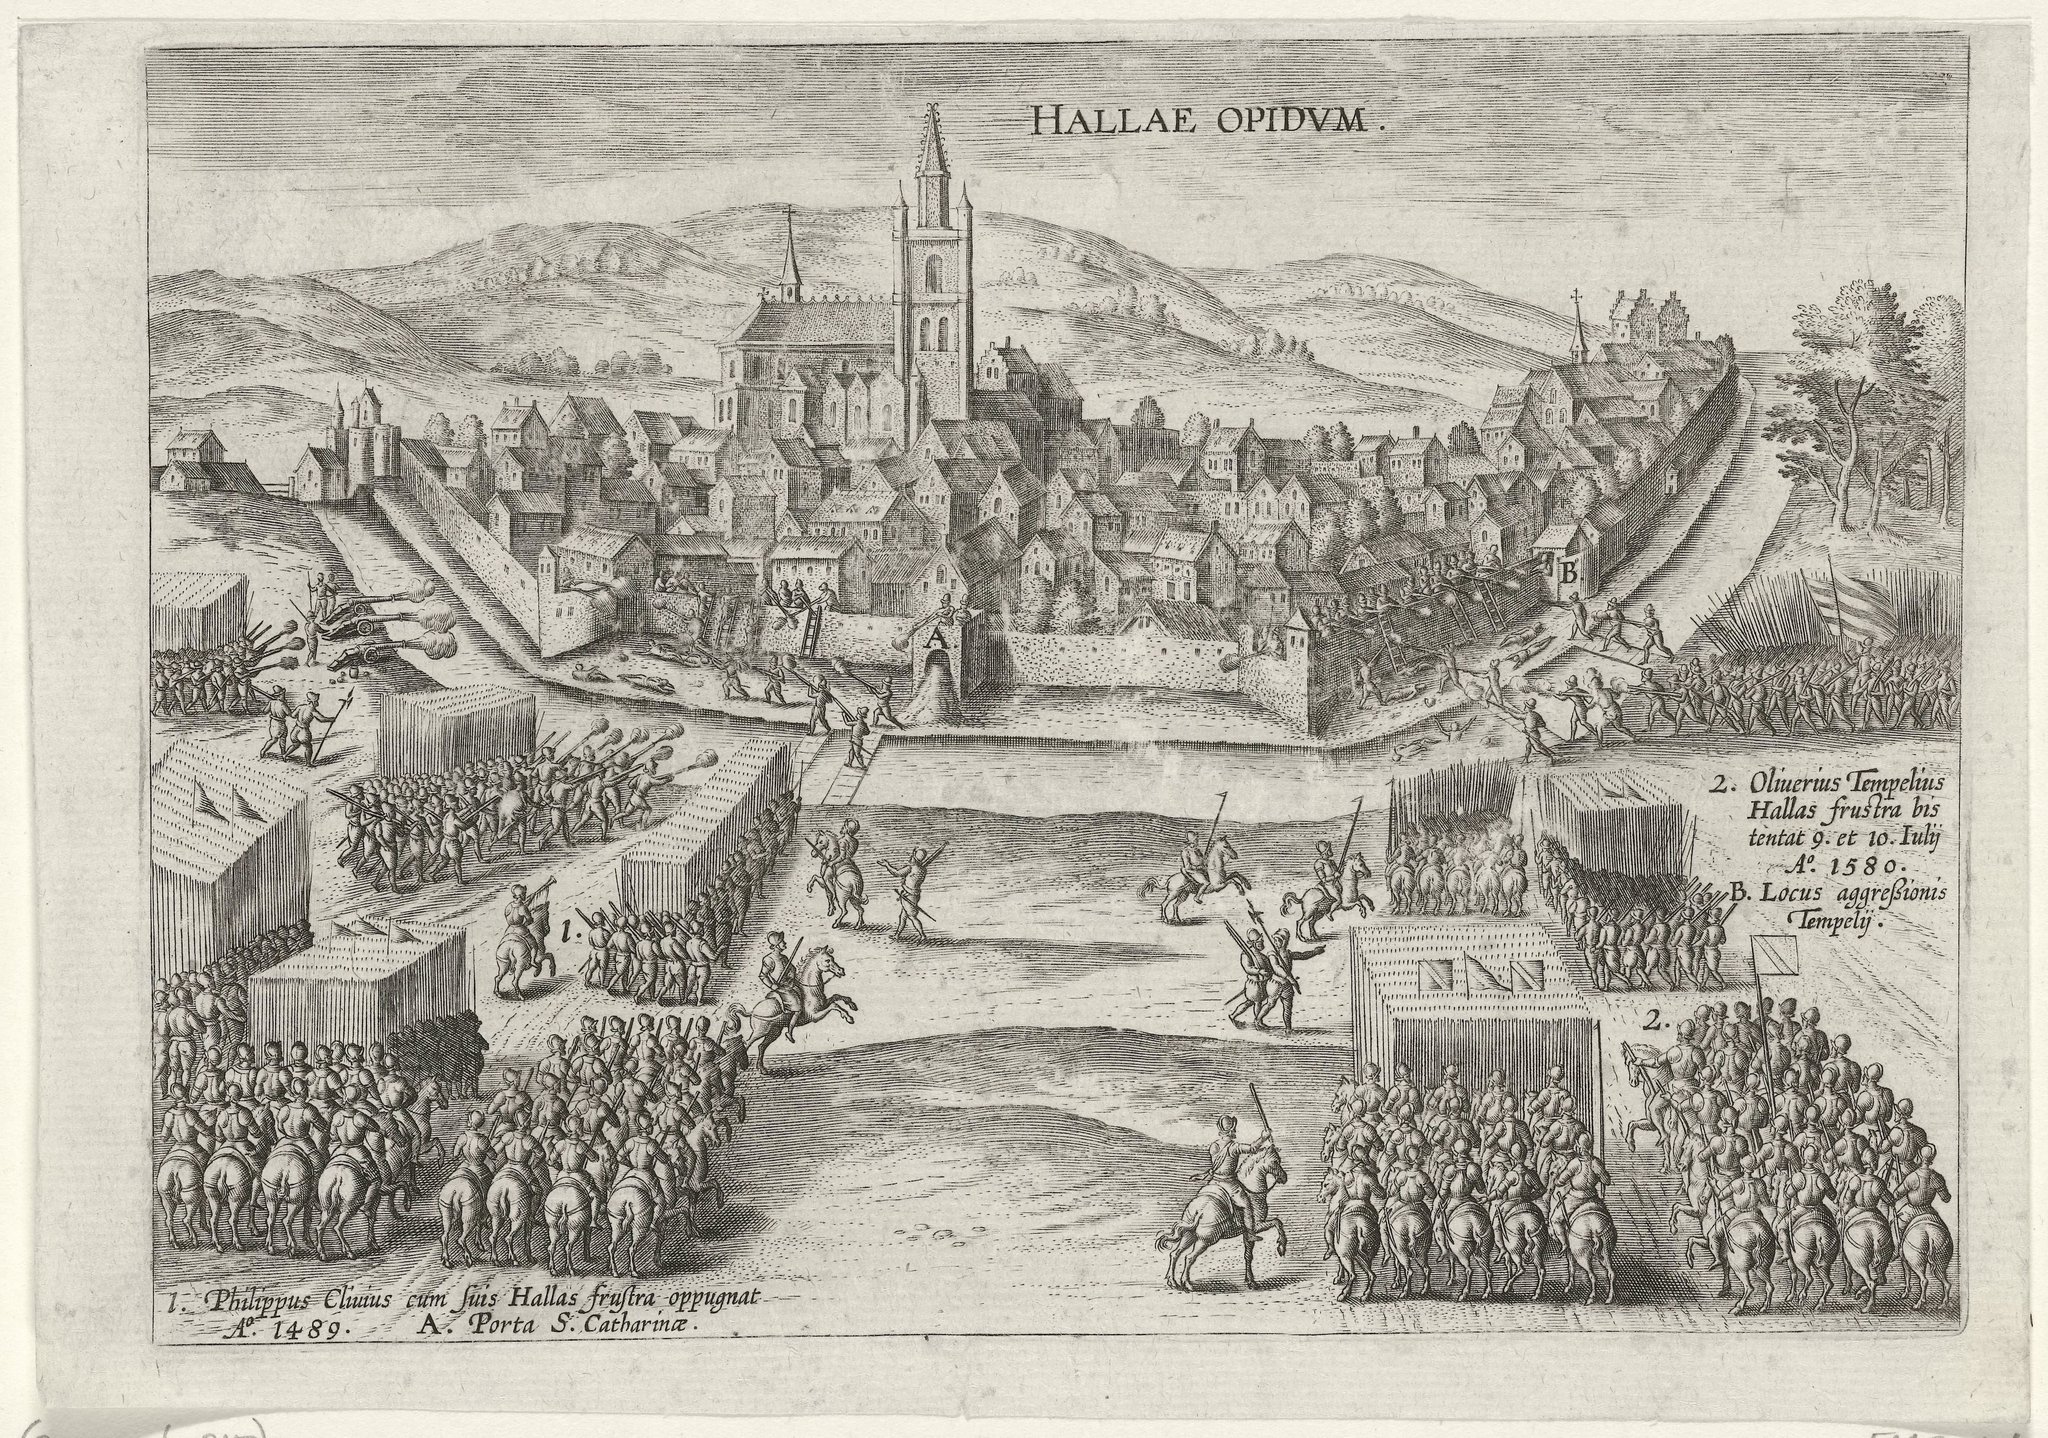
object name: print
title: Hallae Opidum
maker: Anonymous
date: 1580-1599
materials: paper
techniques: engraving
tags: siege, position war, halle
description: Twee vergeefse aanvallen door Olivier van den Tympel op de stad Halle op 9 en 10 juli 1580. Gezicht op de versterkte stad met de legers buiten de stadsmuren. Links het leger van Filips van Kleef die in 1489 ook tevergeefs de stad aanviel. Opschriften in de voorstelling in het Latijn.